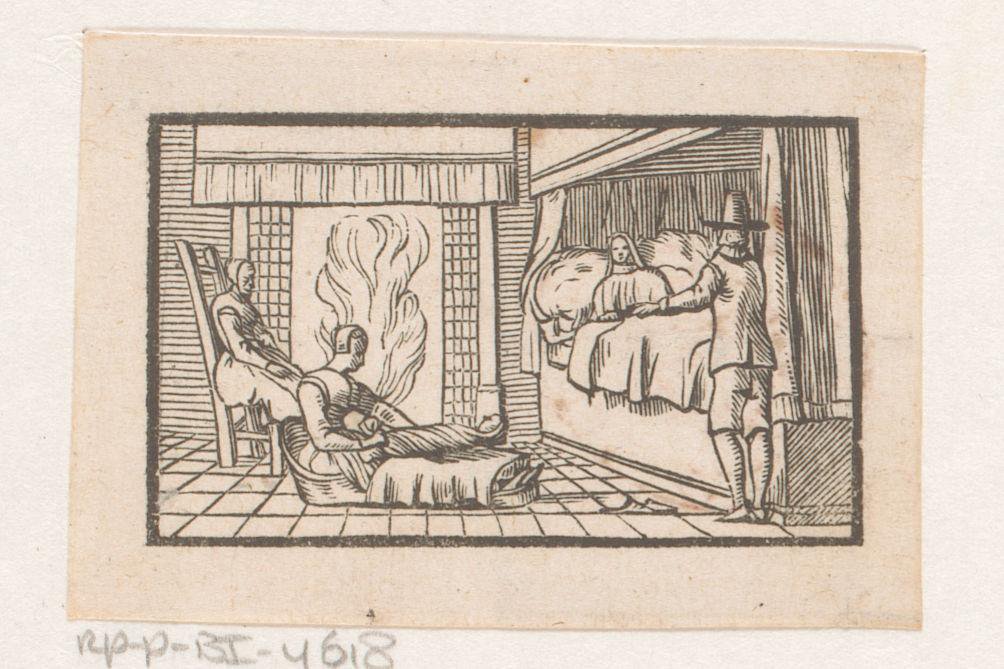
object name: print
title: Interieur met een aantal figuren bij een haard en een vrouw liggend in bed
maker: Anonymous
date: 1600-1699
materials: paper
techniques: woodcut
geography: netherlands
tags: adult woman (+ lying), open hearth, fire-place, adult man (+ standing), adult woman (+ sitting), infant, baby ~ the ages of man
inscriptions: collector's mark: Lugt 240